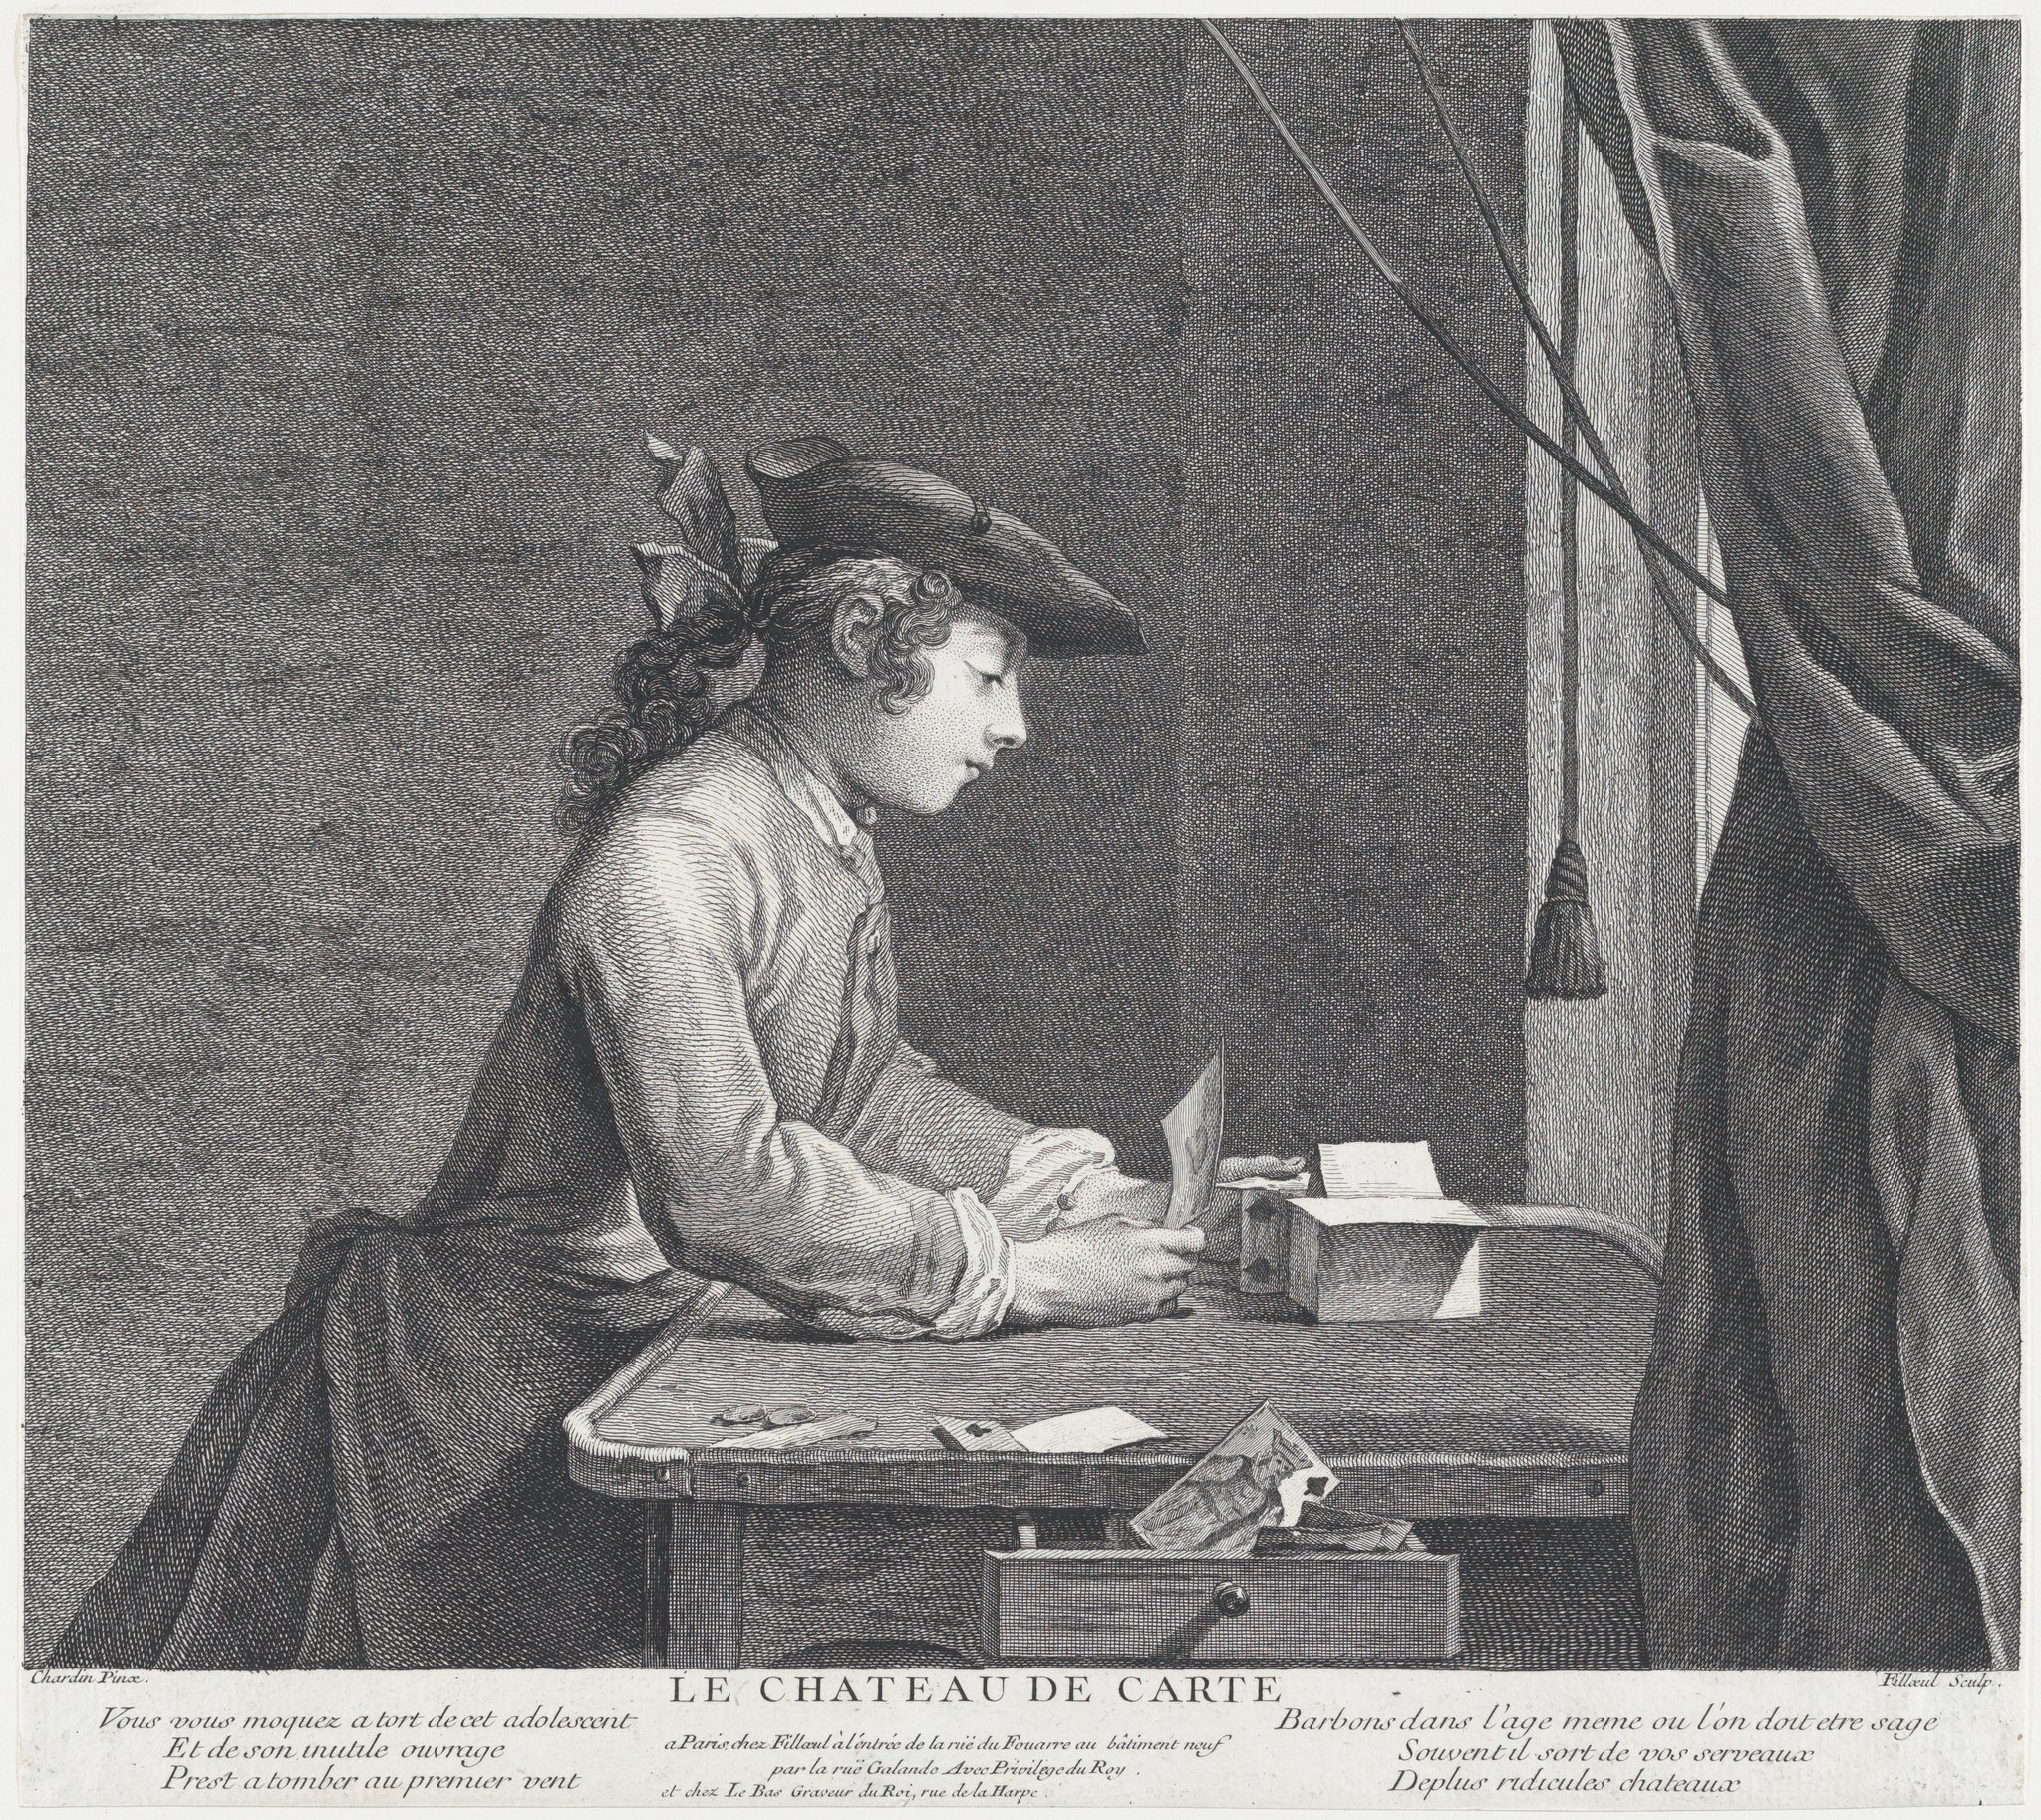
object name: print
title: The House of Cards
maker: pierre filloeul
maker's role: engraver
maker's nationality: french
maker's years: 1696-1754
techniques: engraving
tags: men,playing cards